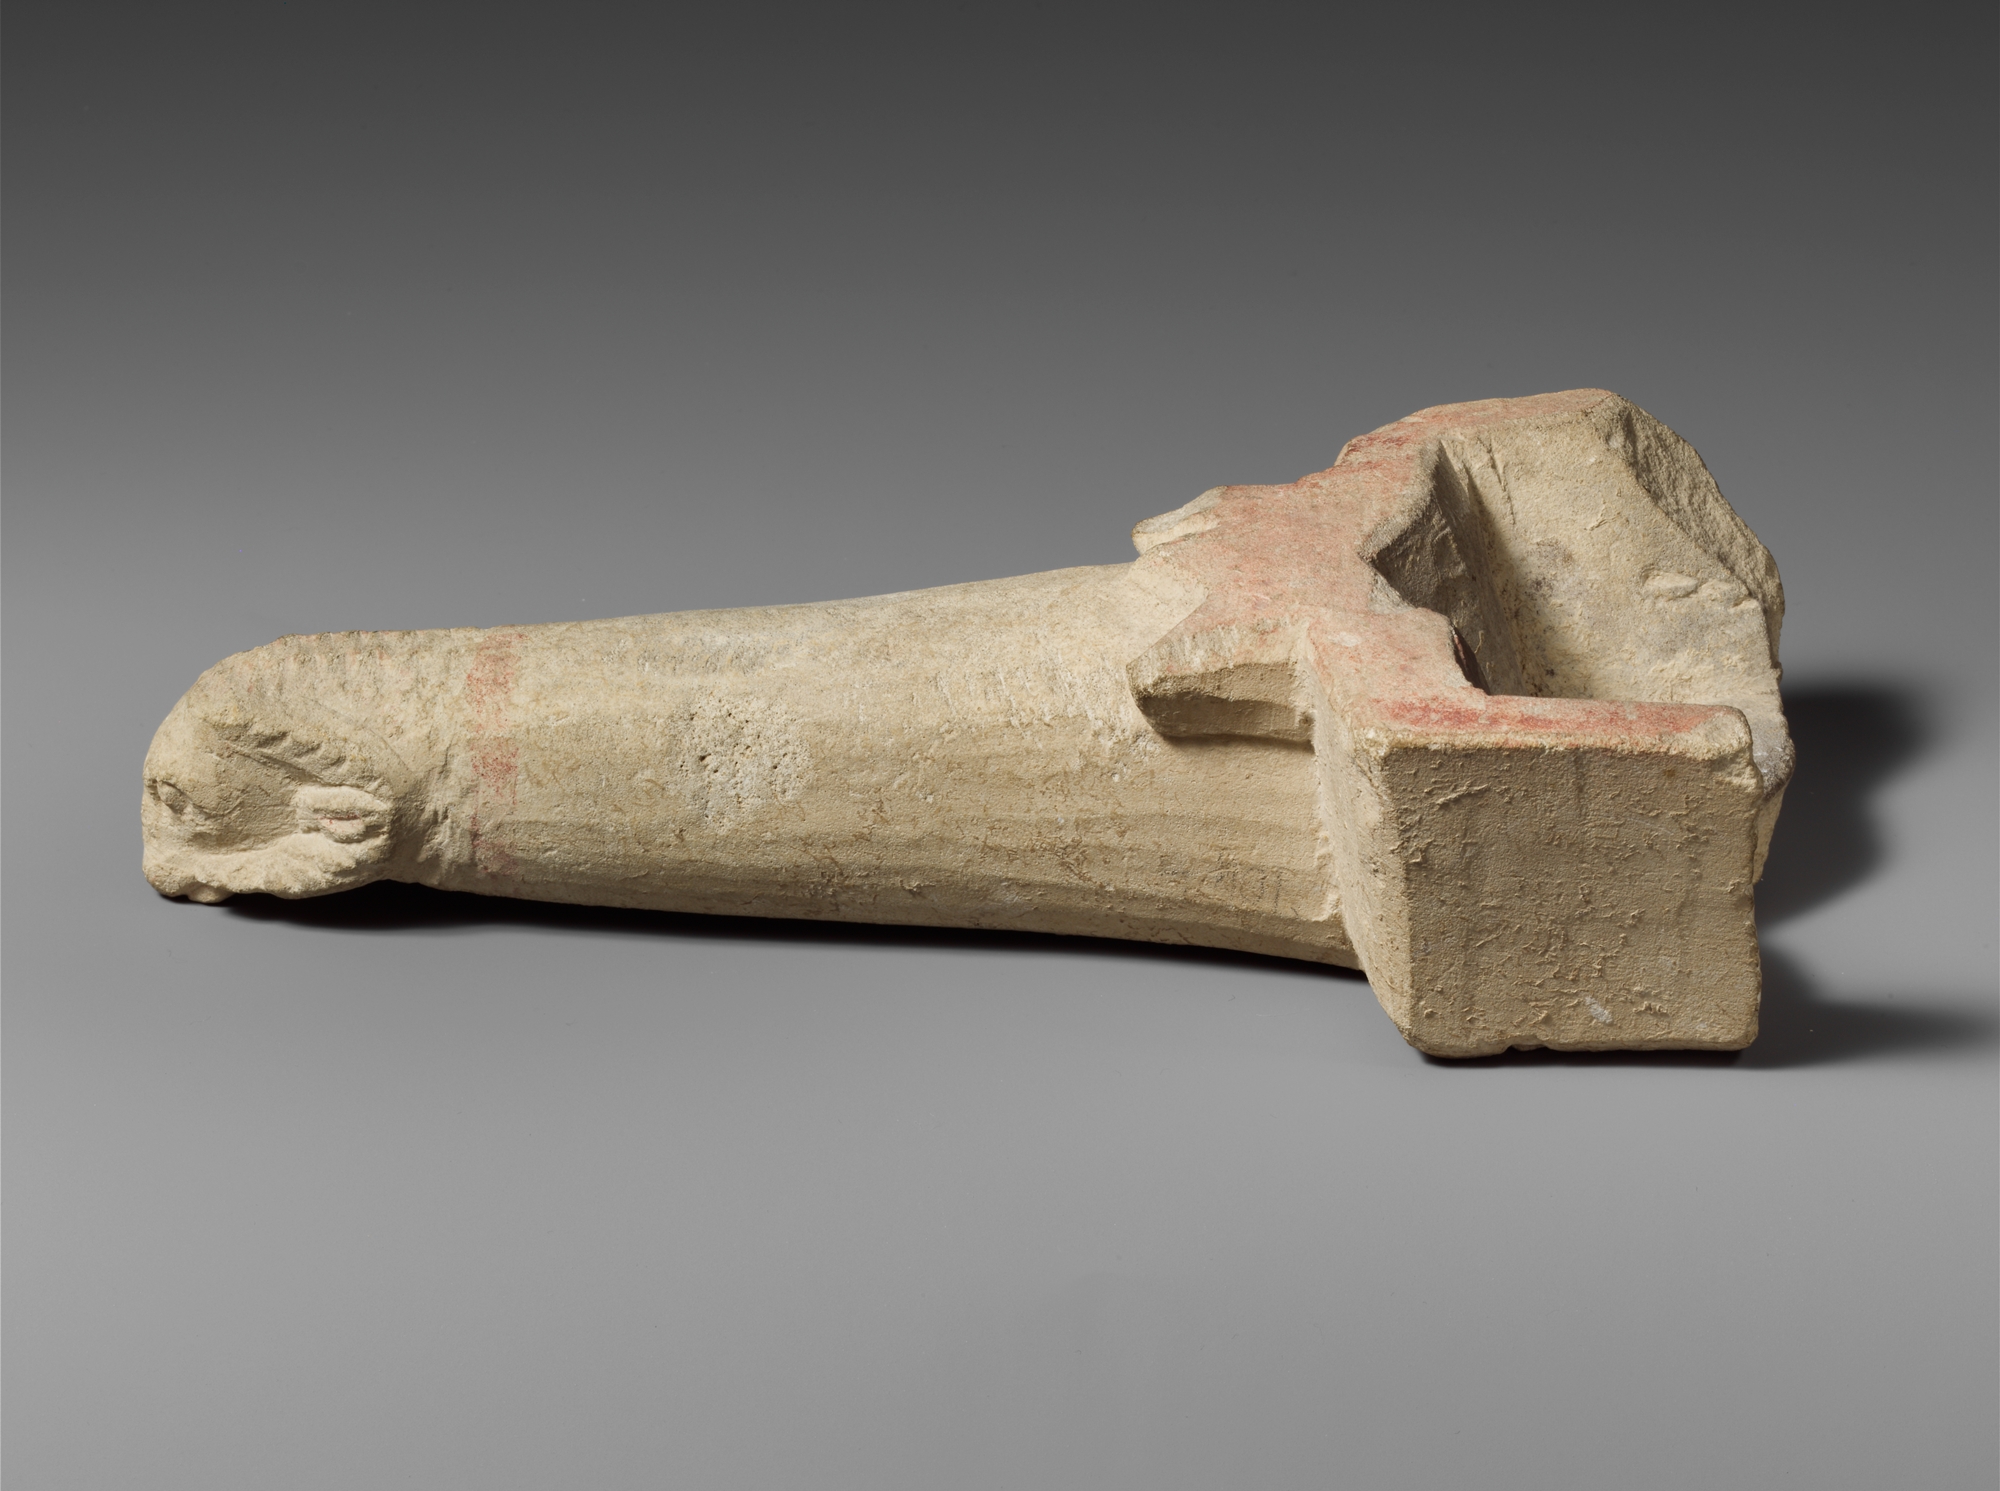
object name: fire shovel handle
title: Limestone handle of a patera or a fire shovel ending in a ram’s head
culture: cypriot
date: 500-401 BCE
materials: limestone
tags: rams